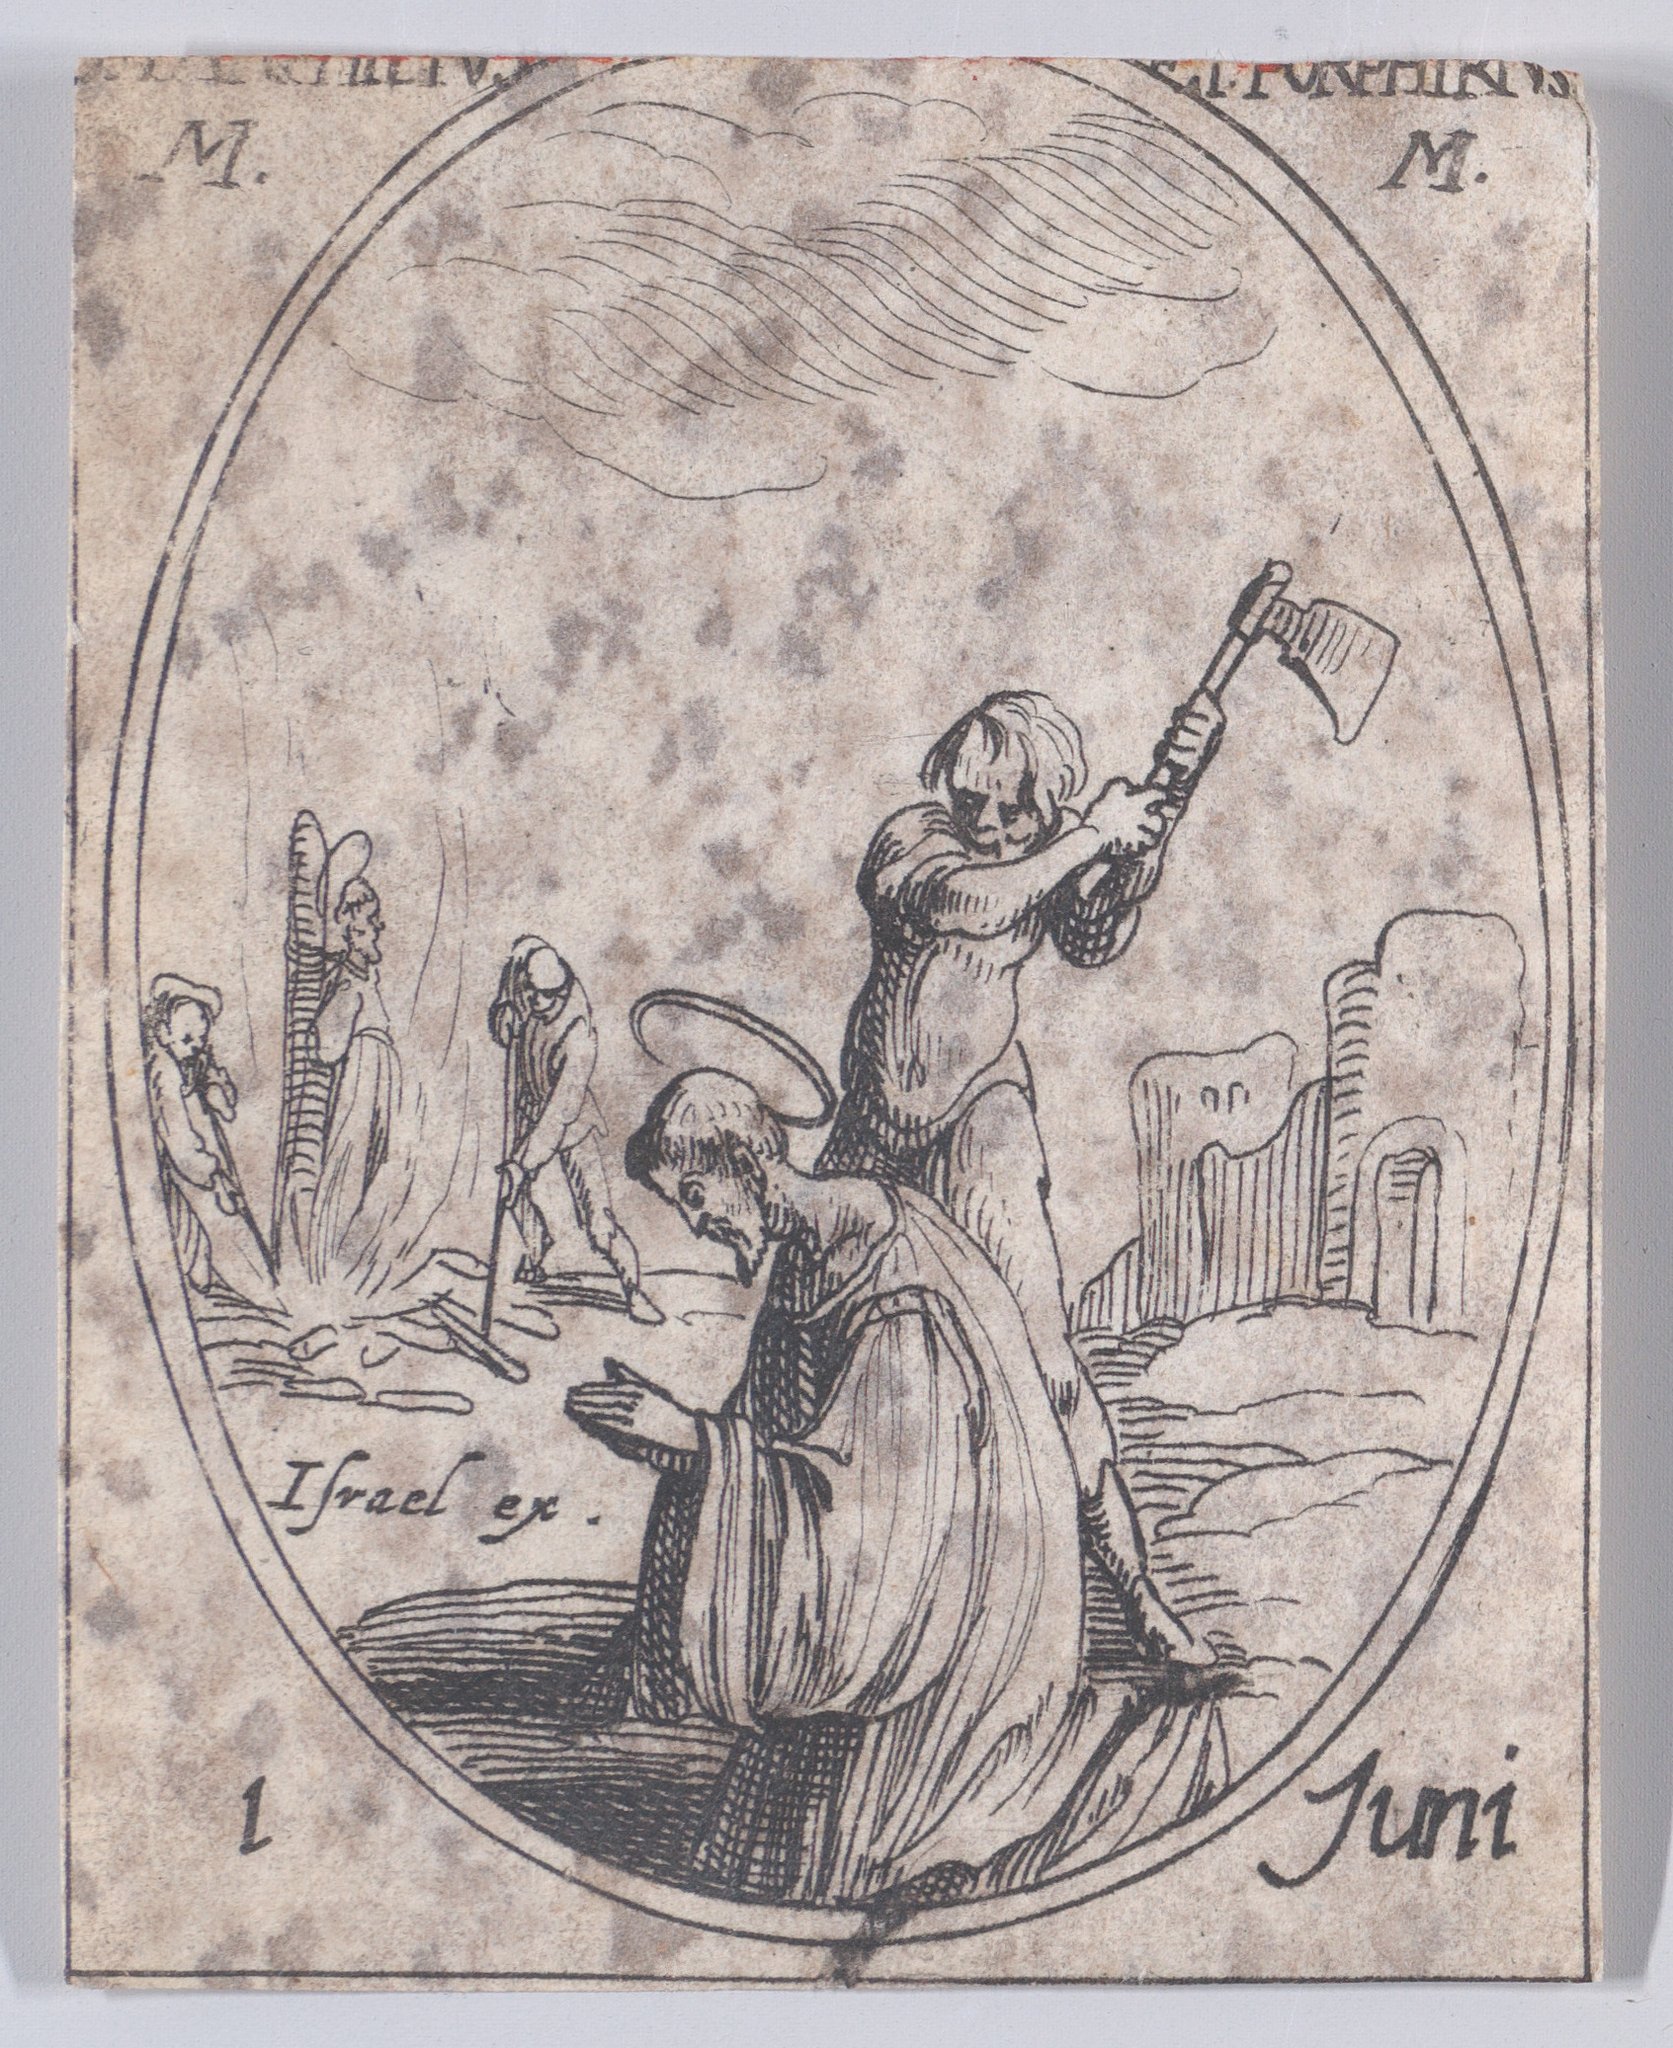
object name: print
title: S. Pamphile et S. Porphyre, martyrs (St. Pamphilus and St. Porphyrius, Martyrs), June 1st, from "Les Images De Tous Les Saincts et Saintes de L'Année" (Images of All of the Saints and Religious Events of the Year)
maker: jacques callot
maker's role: artist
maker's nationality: french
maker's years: 1592-1635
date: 1636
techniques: etching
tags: men,saints